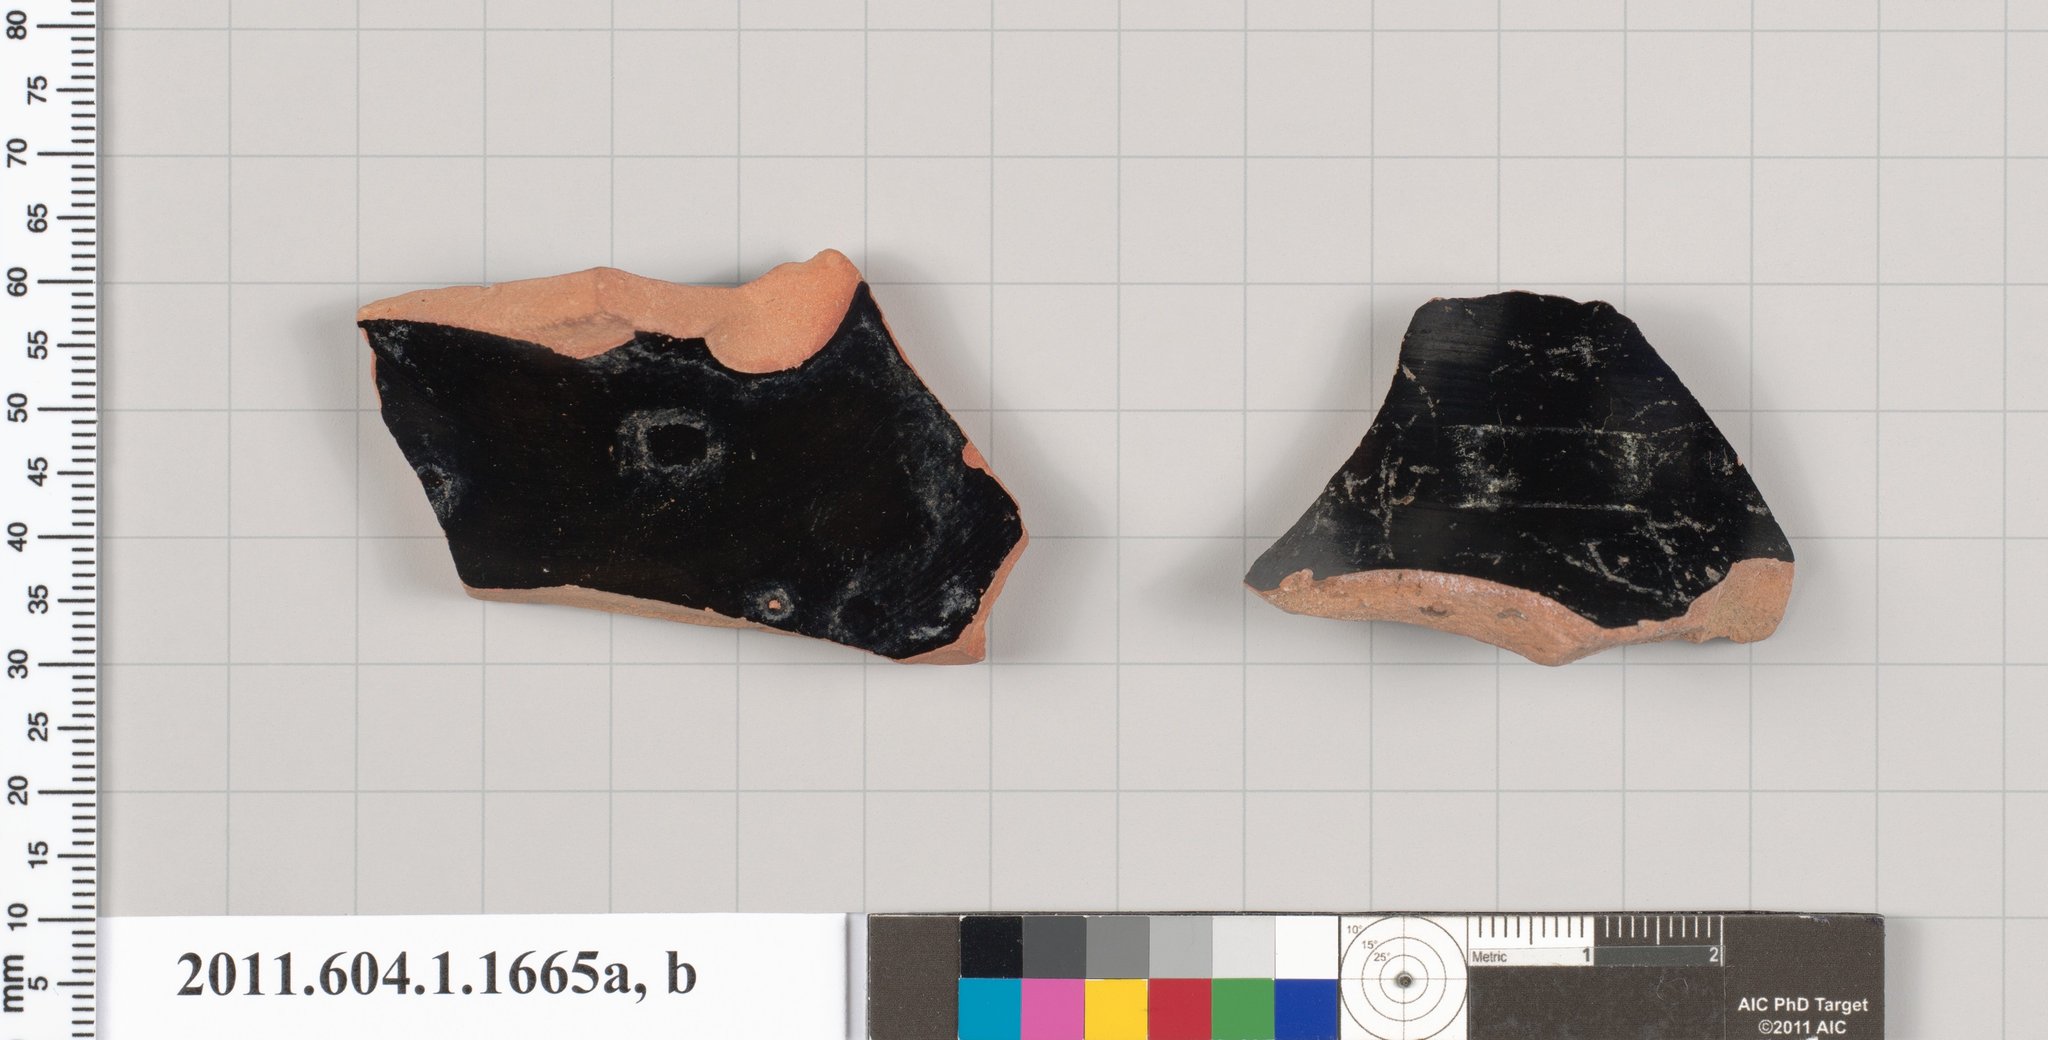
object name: kylix fragment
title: Terracotta fragments of kylikes (drinking cups)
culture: greek, attic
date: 530-510 BCE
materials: terracotta